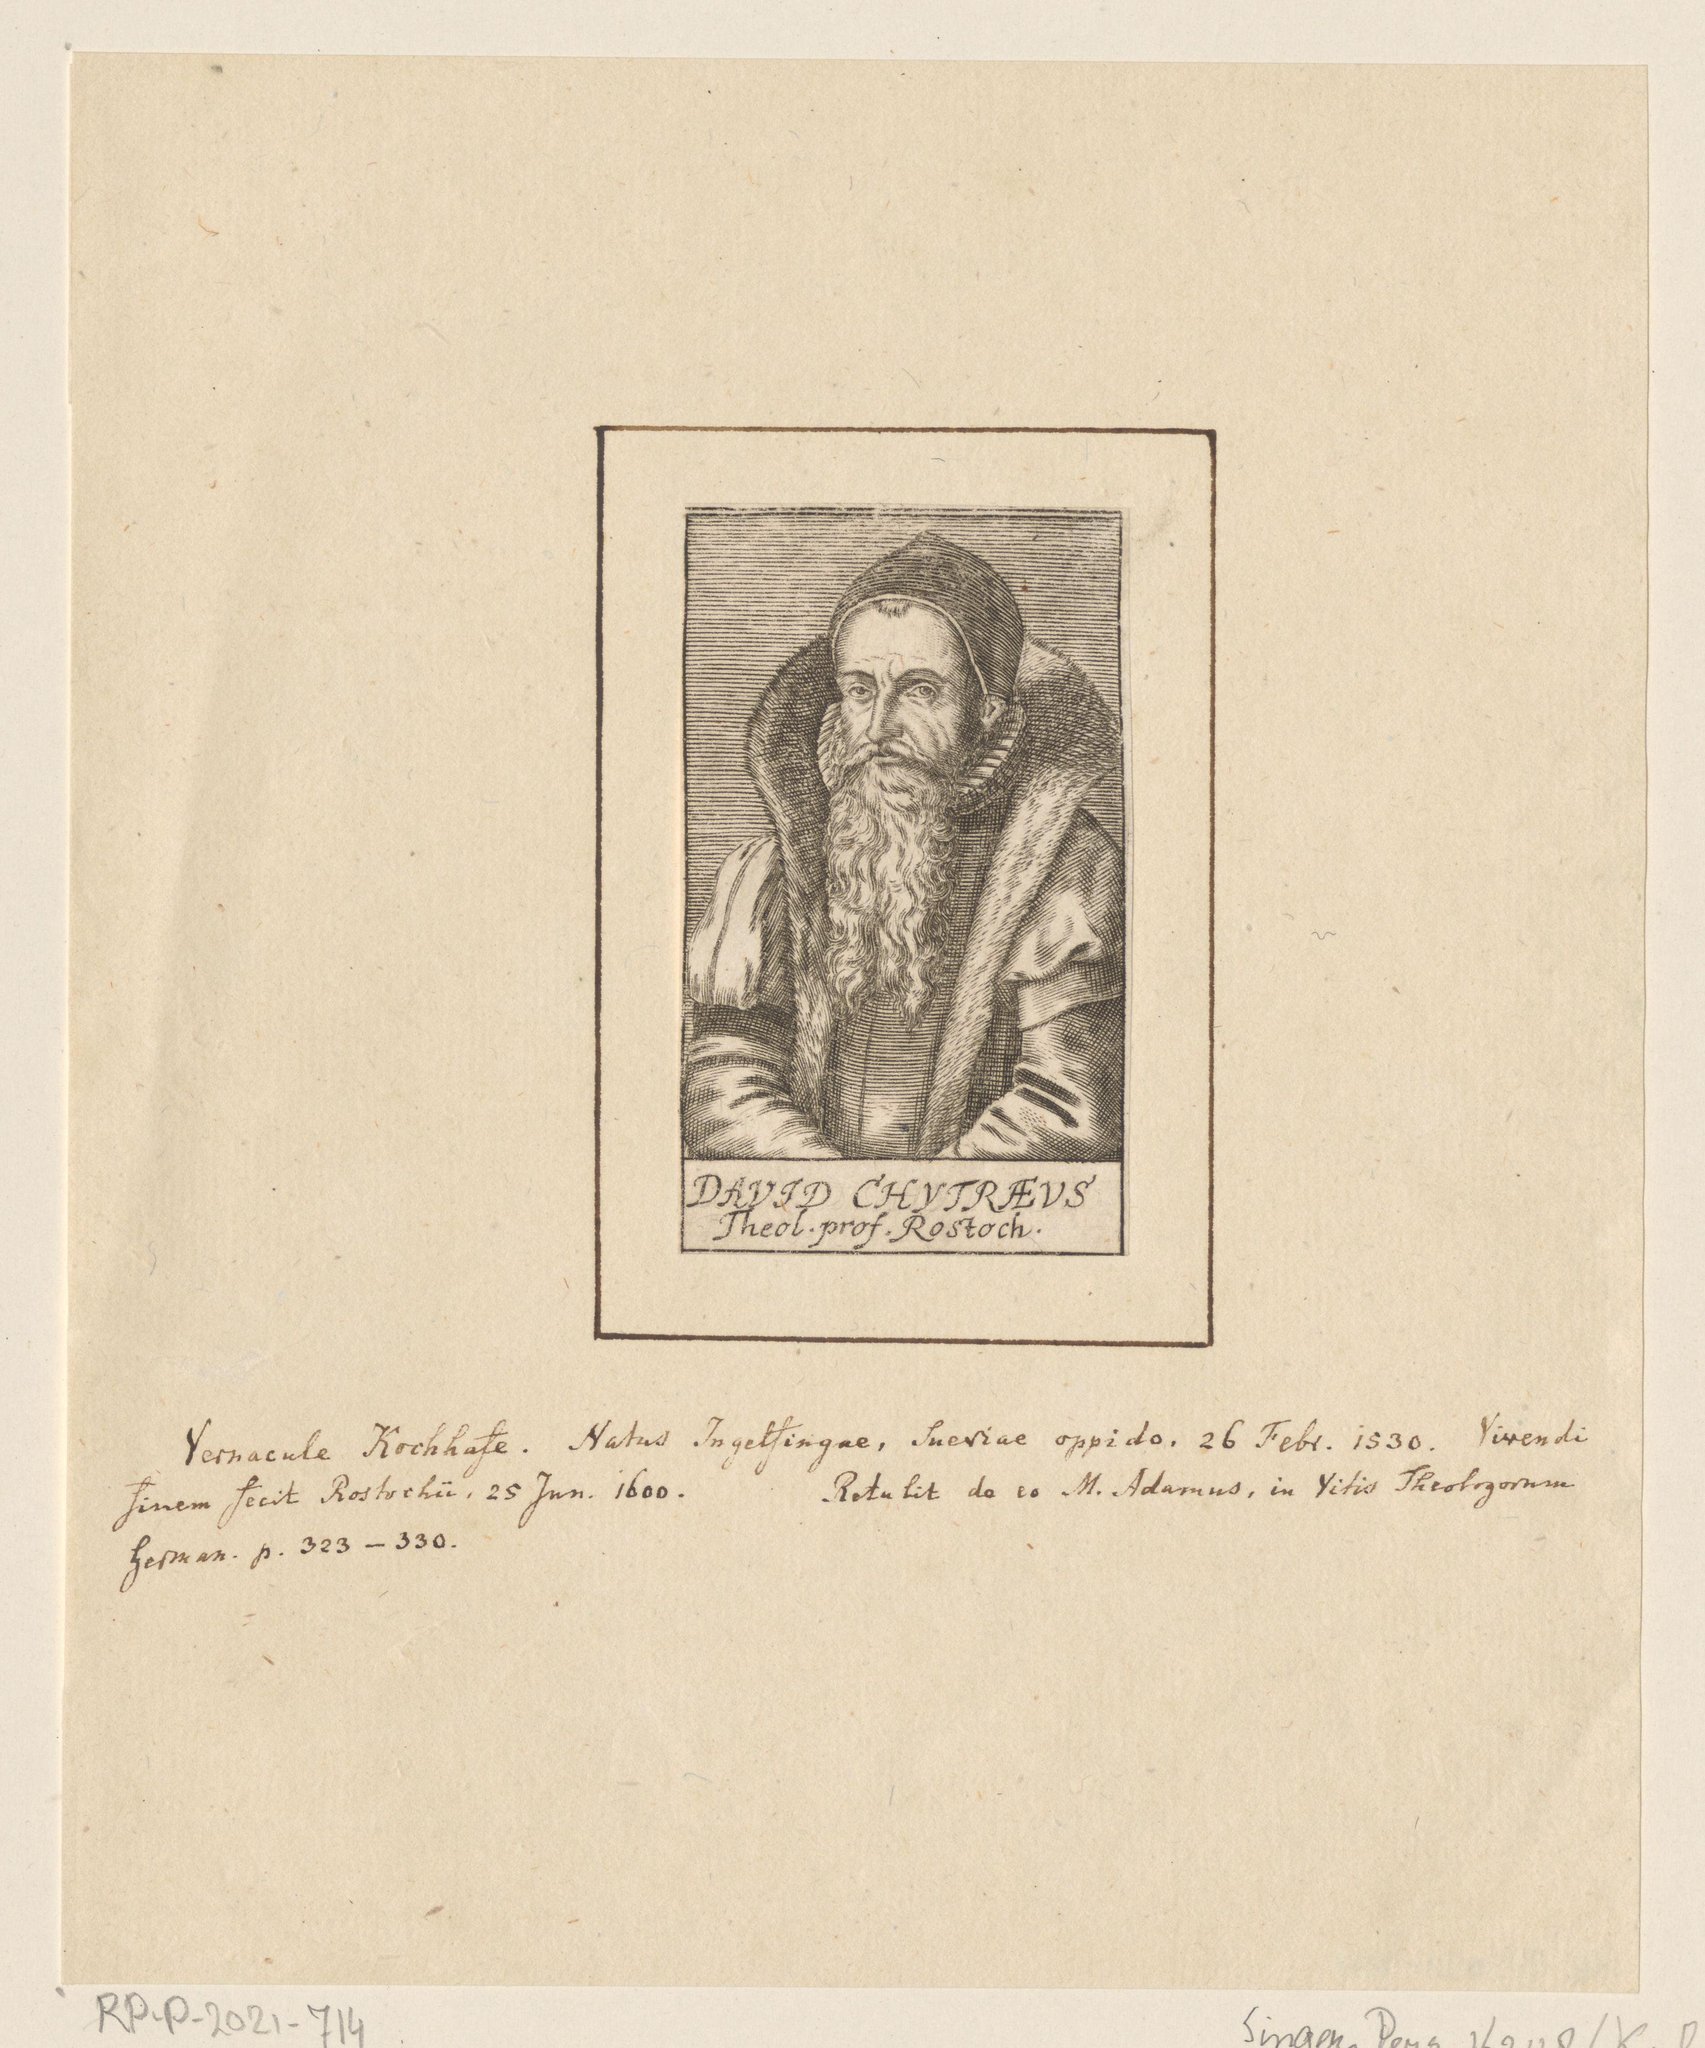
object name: print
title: Portret van David Chytraeus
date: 1688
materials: paper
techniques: engraving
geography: nuremberg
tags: theologian, historical persons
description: Prent waarschijnlijk uit: Freher, Paul. Theatrum virorum eruditione clarorum. Neurenberg: Johann Hoffmann, 1688.